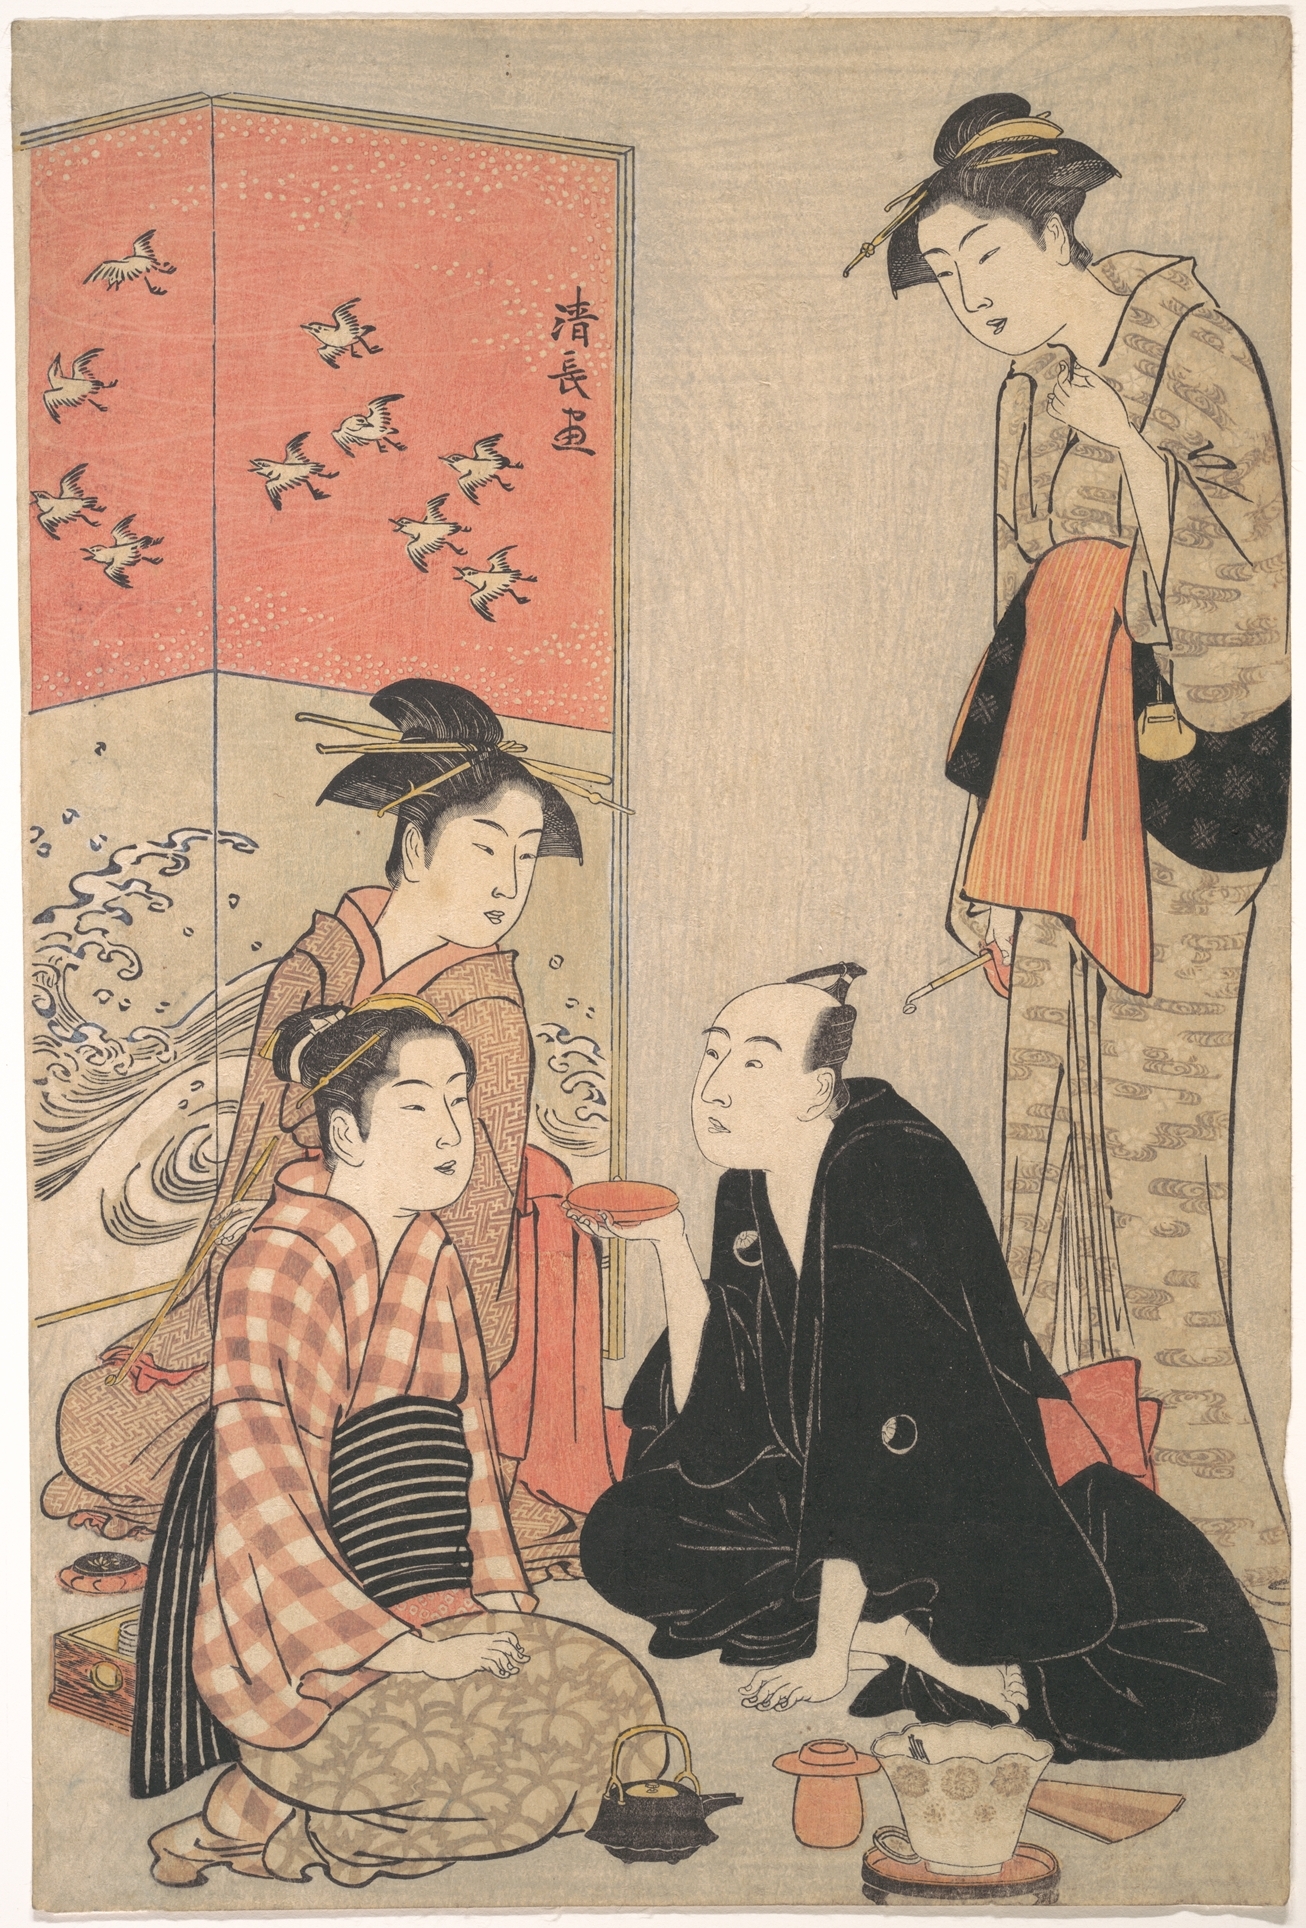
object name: woodblock print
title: The Kabuki Actor Sawamura Sōjūrō III and Courtesans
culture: japanese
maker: torii kiyonaga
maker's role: artist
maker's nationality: japanese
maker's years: 1752-1815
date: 1783-1784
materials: ink, paper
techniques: woodblock print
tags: men,women,actors,screens